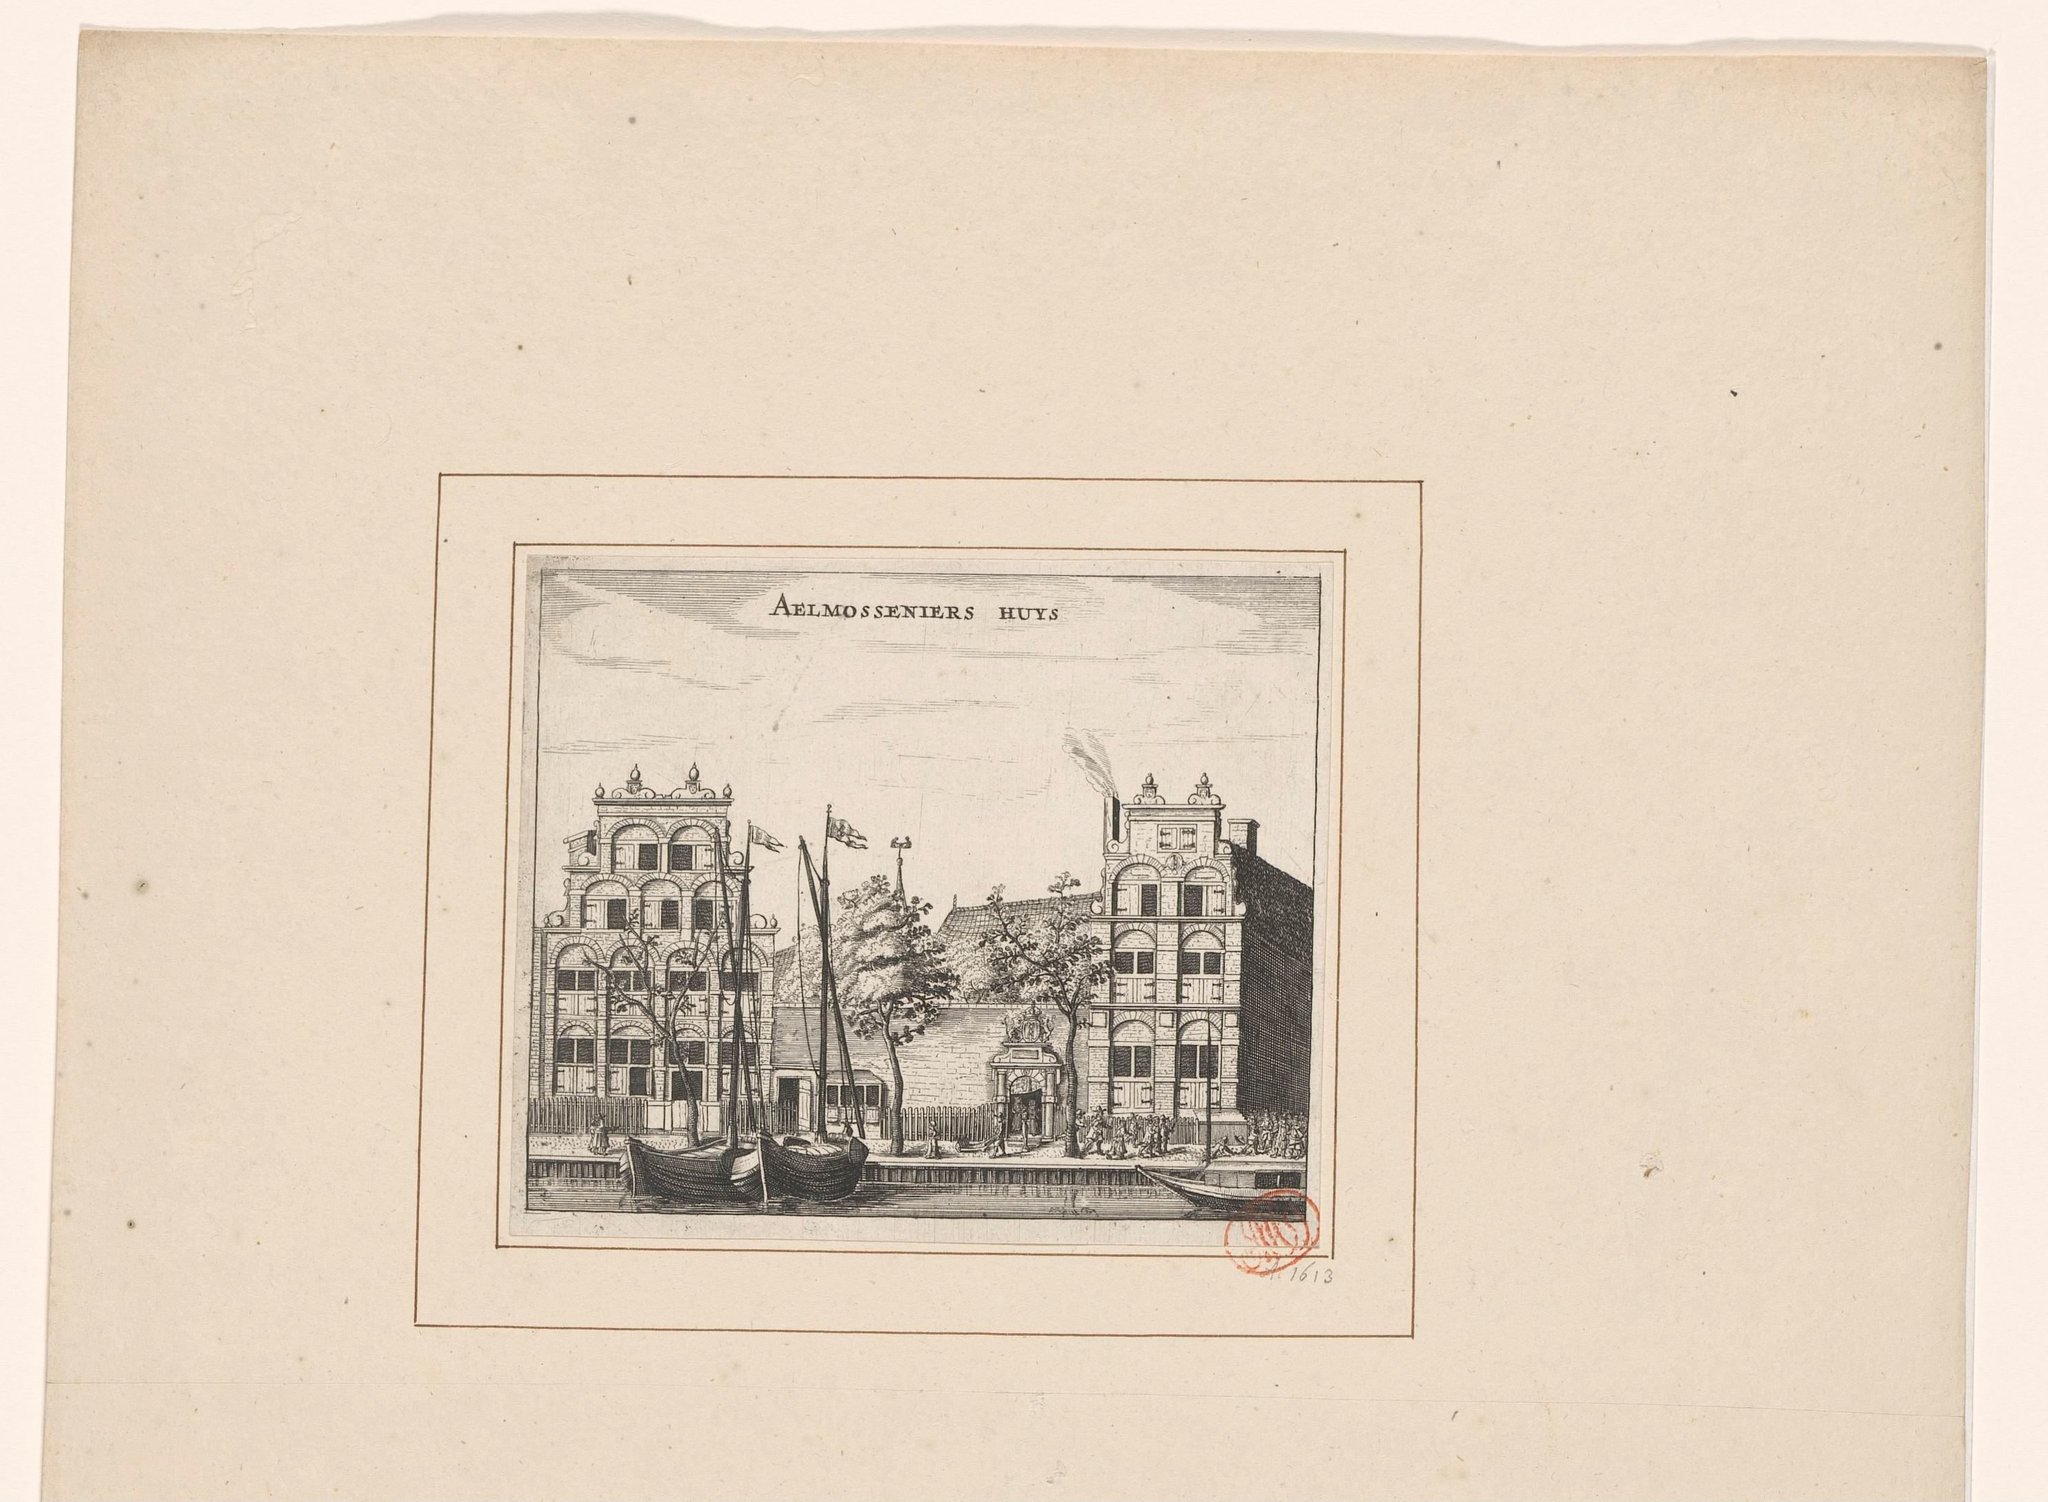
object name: book illustration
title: Aelmosseniers Huys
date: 1664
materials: paper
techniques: engraving, etching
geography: amsterdam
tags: public welfare, poorhouse, orphanage, canals, waters (in city) (+ city(-scape) with figures, staffage), street (+ city(-scape) with figures, staffage)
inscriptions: collector's mark: Lugt 195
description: Huidige staat van prent ook gebruikt in: Fockens, Melchior. Beschrijving Der wijdt-vermaarde Koop-stadt Amstelredam, Van haar eerste beginselen, zedert den Jare 1203. oude Voorrechten, verscheyde Vergrootingenoude Voor-rechten, en verscheyde Vergrootingen (…). 3e druk. Amsterdam: Marcus Willemsz. Doornick, 1664. En in: Zesen, Philipp von. Beschrybung der Weidtberuhmde Kauf-Stadt Amstelredam / Beschreibung der Stadt Amsterdam darinnen von derselben ersten ursprunge bis auf gegenwartigen zustand (…). Amsterdam: Marcus Willemsz. Doornick, 1664. Tweede bekende staat (met toevoeging Franse titel) ook gebruikt in: Domselaer, Tobias en Isaac Commelin. Beschryvinge van Amsterdam : haar eerste oorspronk uyt den huyze der heeren van Aemstel en Aemstellant (…). 6 delen. Amsterdam: Marcus Willemsz van Doornick, 1665. In tegenstelling tot meeste prenten uit bovenstaande publicaties is deze prent niet aangepast naar een derde staat en niet gebruikt in verschillende latere zeventiende- en achttiende-eeuwse publicaties.